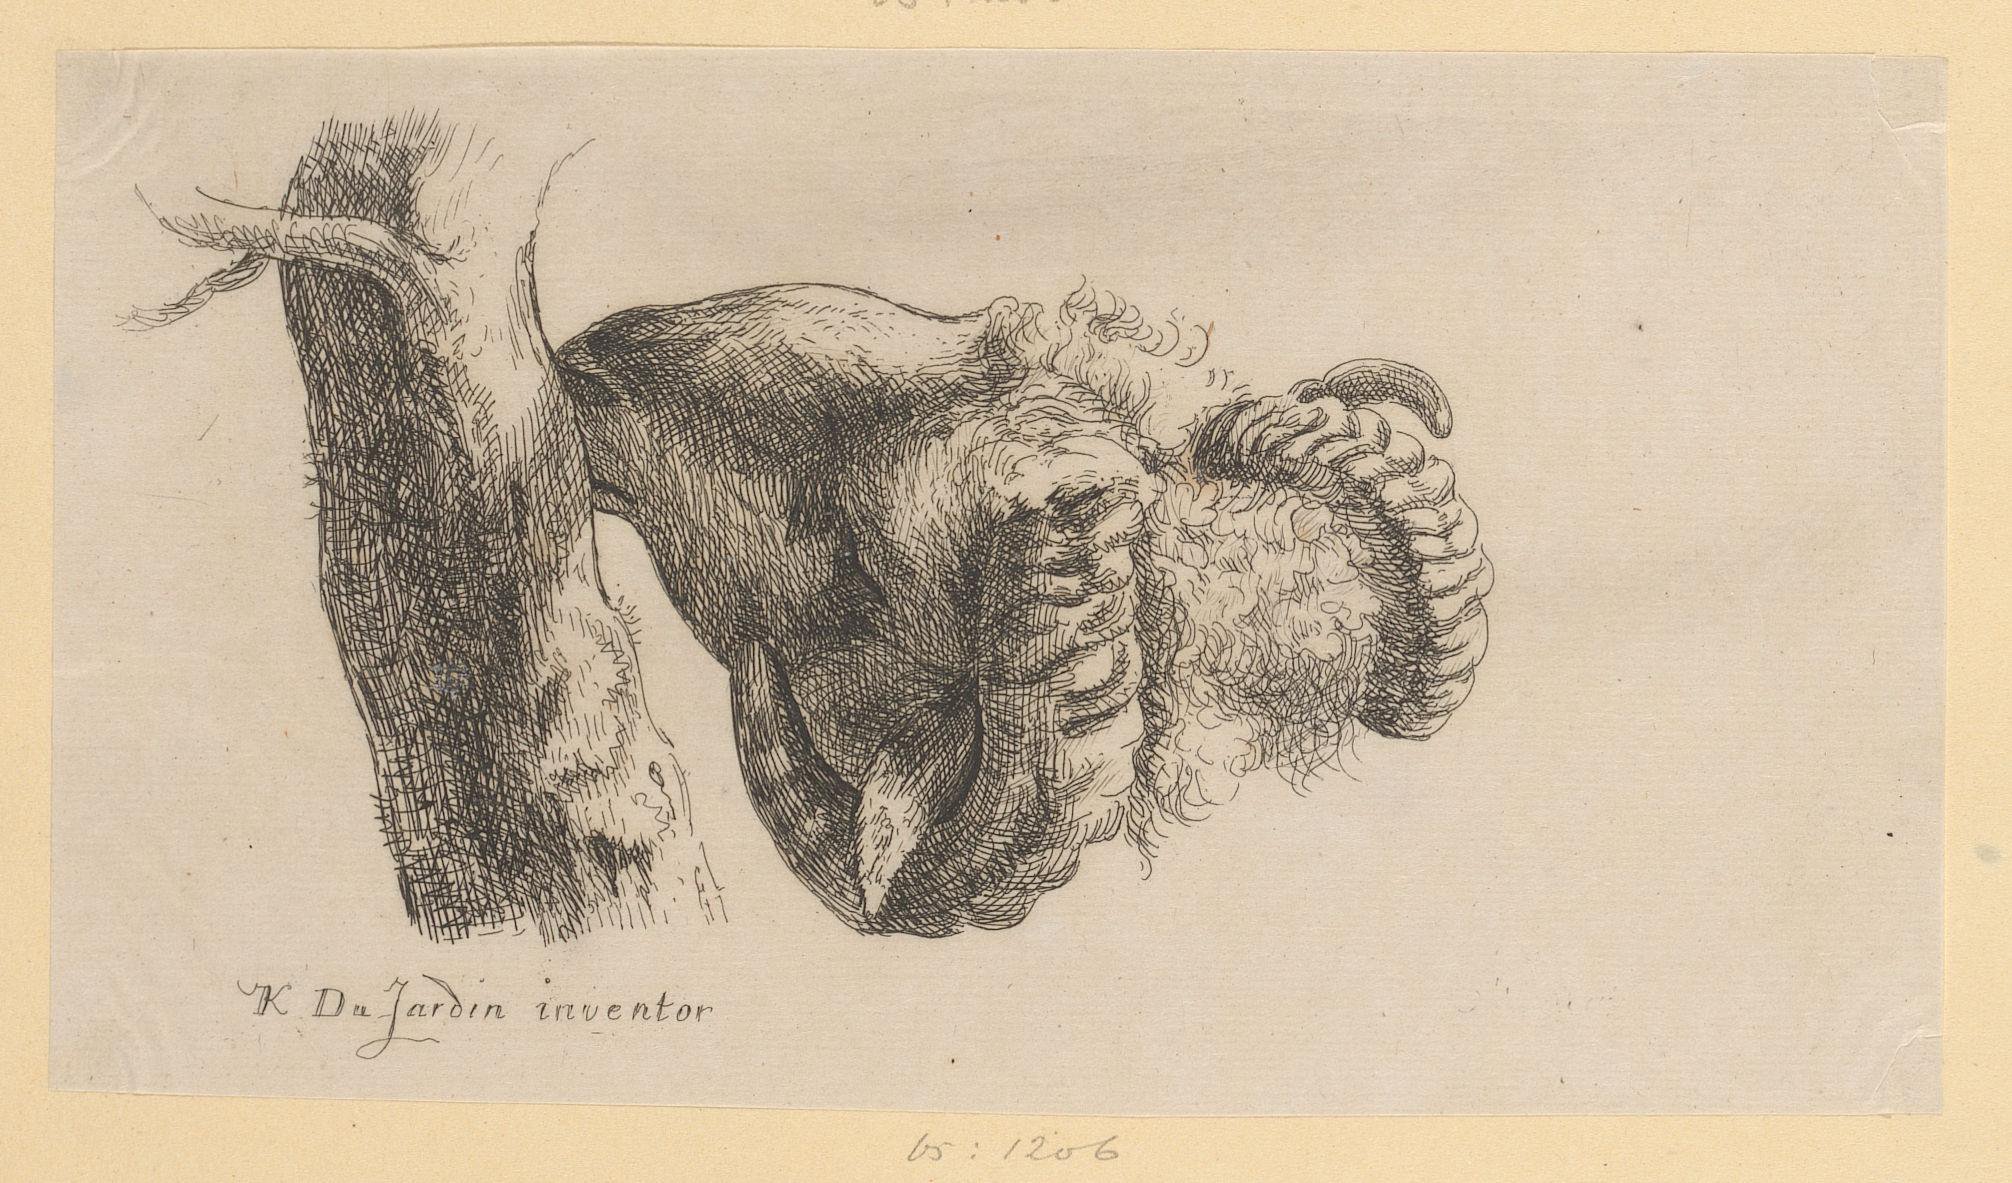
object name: album leaf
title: Ramskop bij een boomstam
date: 1805-1844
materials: paper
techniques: etching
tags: ram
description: Prent maakt deel uit van een serie van 11 prenten. Prent maakt mogelijk deel uit van een serie van 200 prenten. Deze serie is onder de titel 'A Collection of two hundred original etchings' voor het eerst uitgegeven door J.M. Greery in 1816.